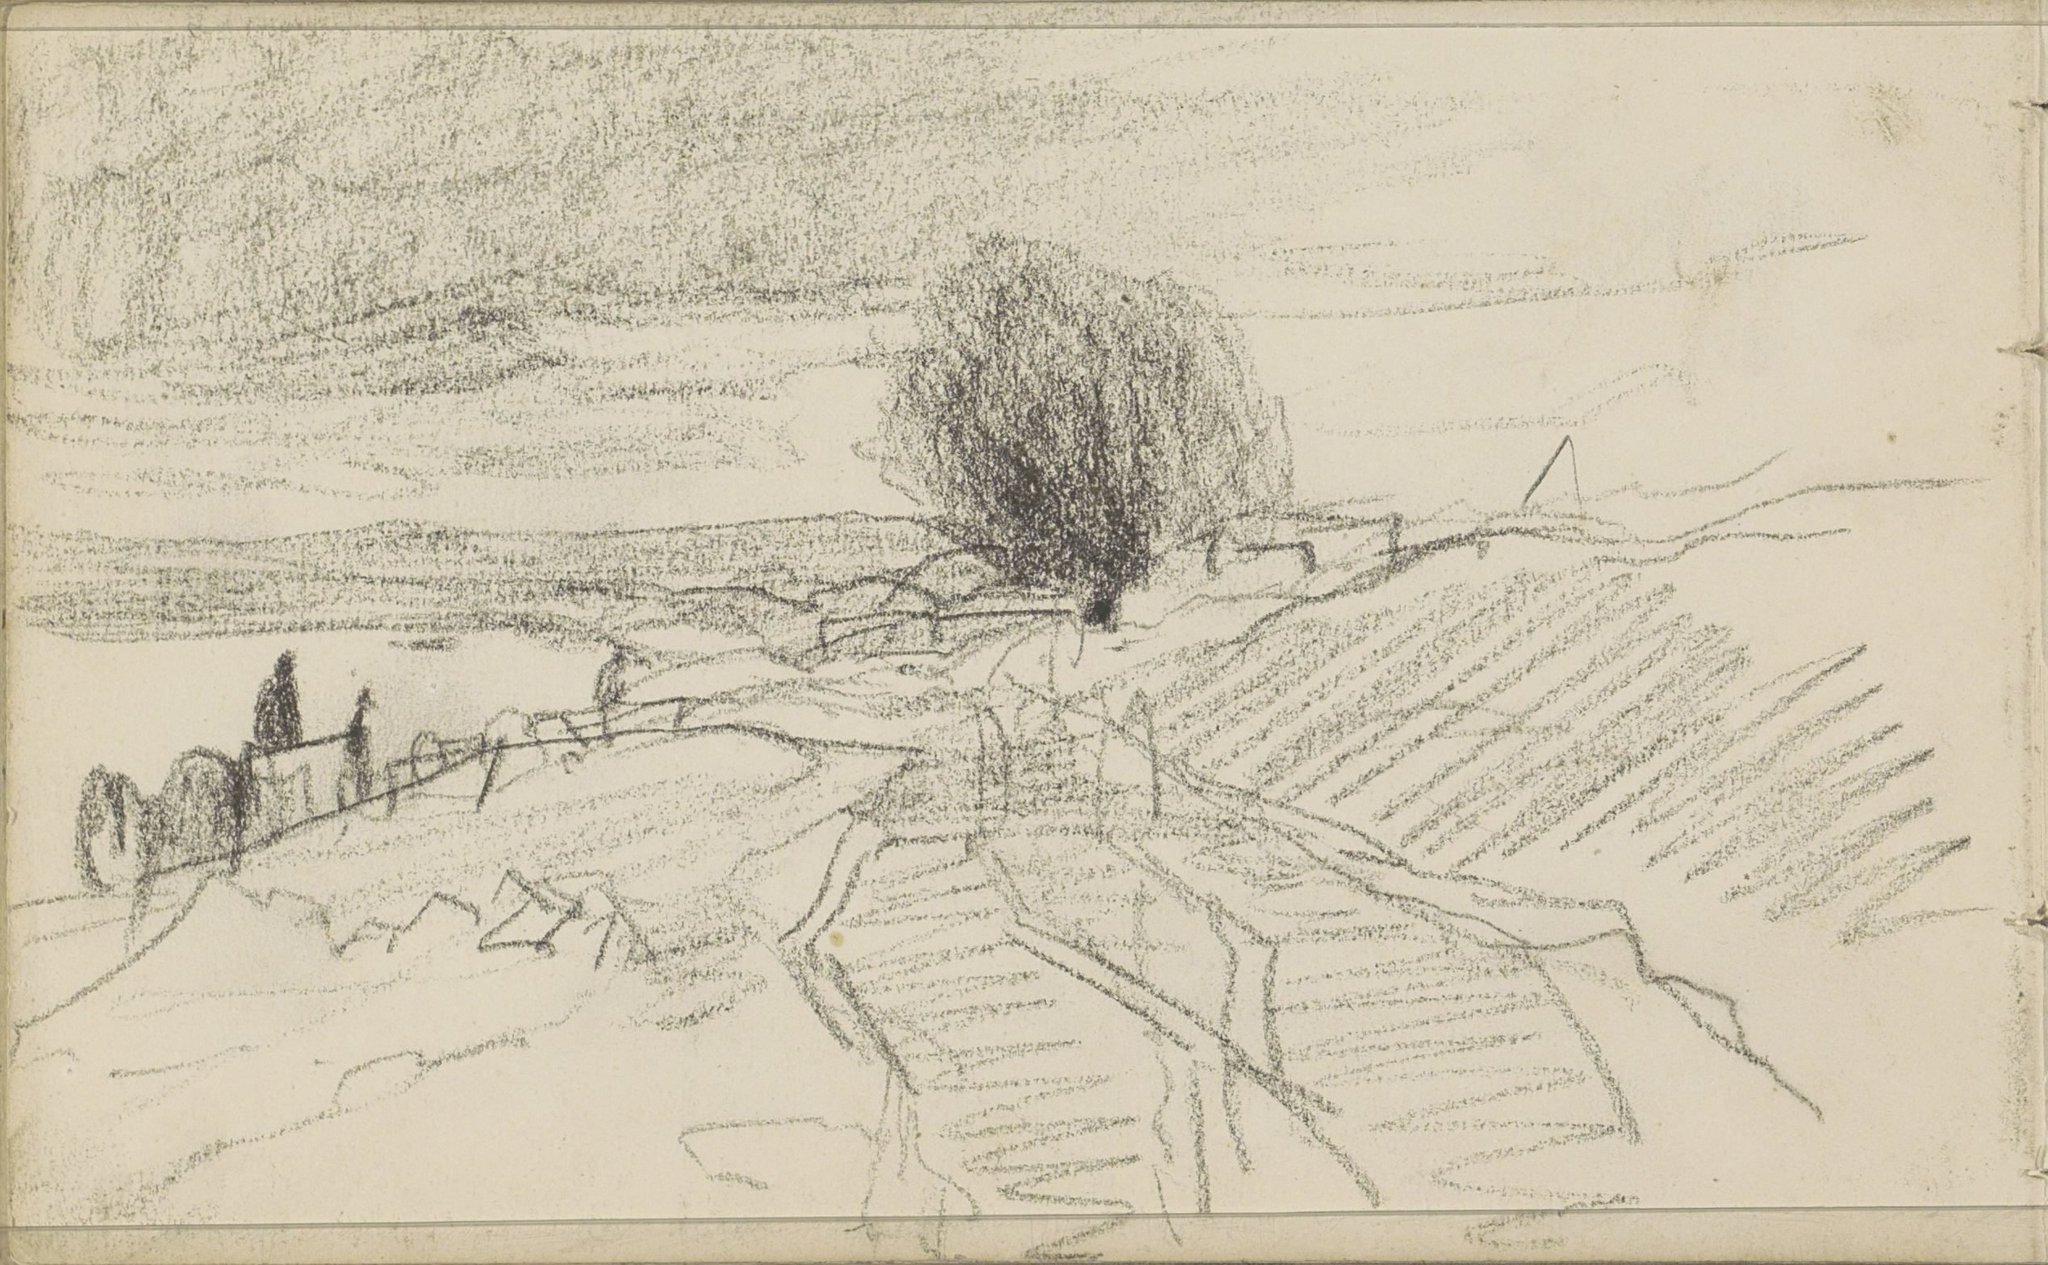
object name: sketchbook leaf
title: Landschap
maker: anton mauve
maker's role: draughtsman, painter, print maker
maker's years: 1838-1888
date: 1848-1888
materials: chalk, paper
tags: landscapes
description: Blad 35 verso uit een schetsboek met 42 bladen.